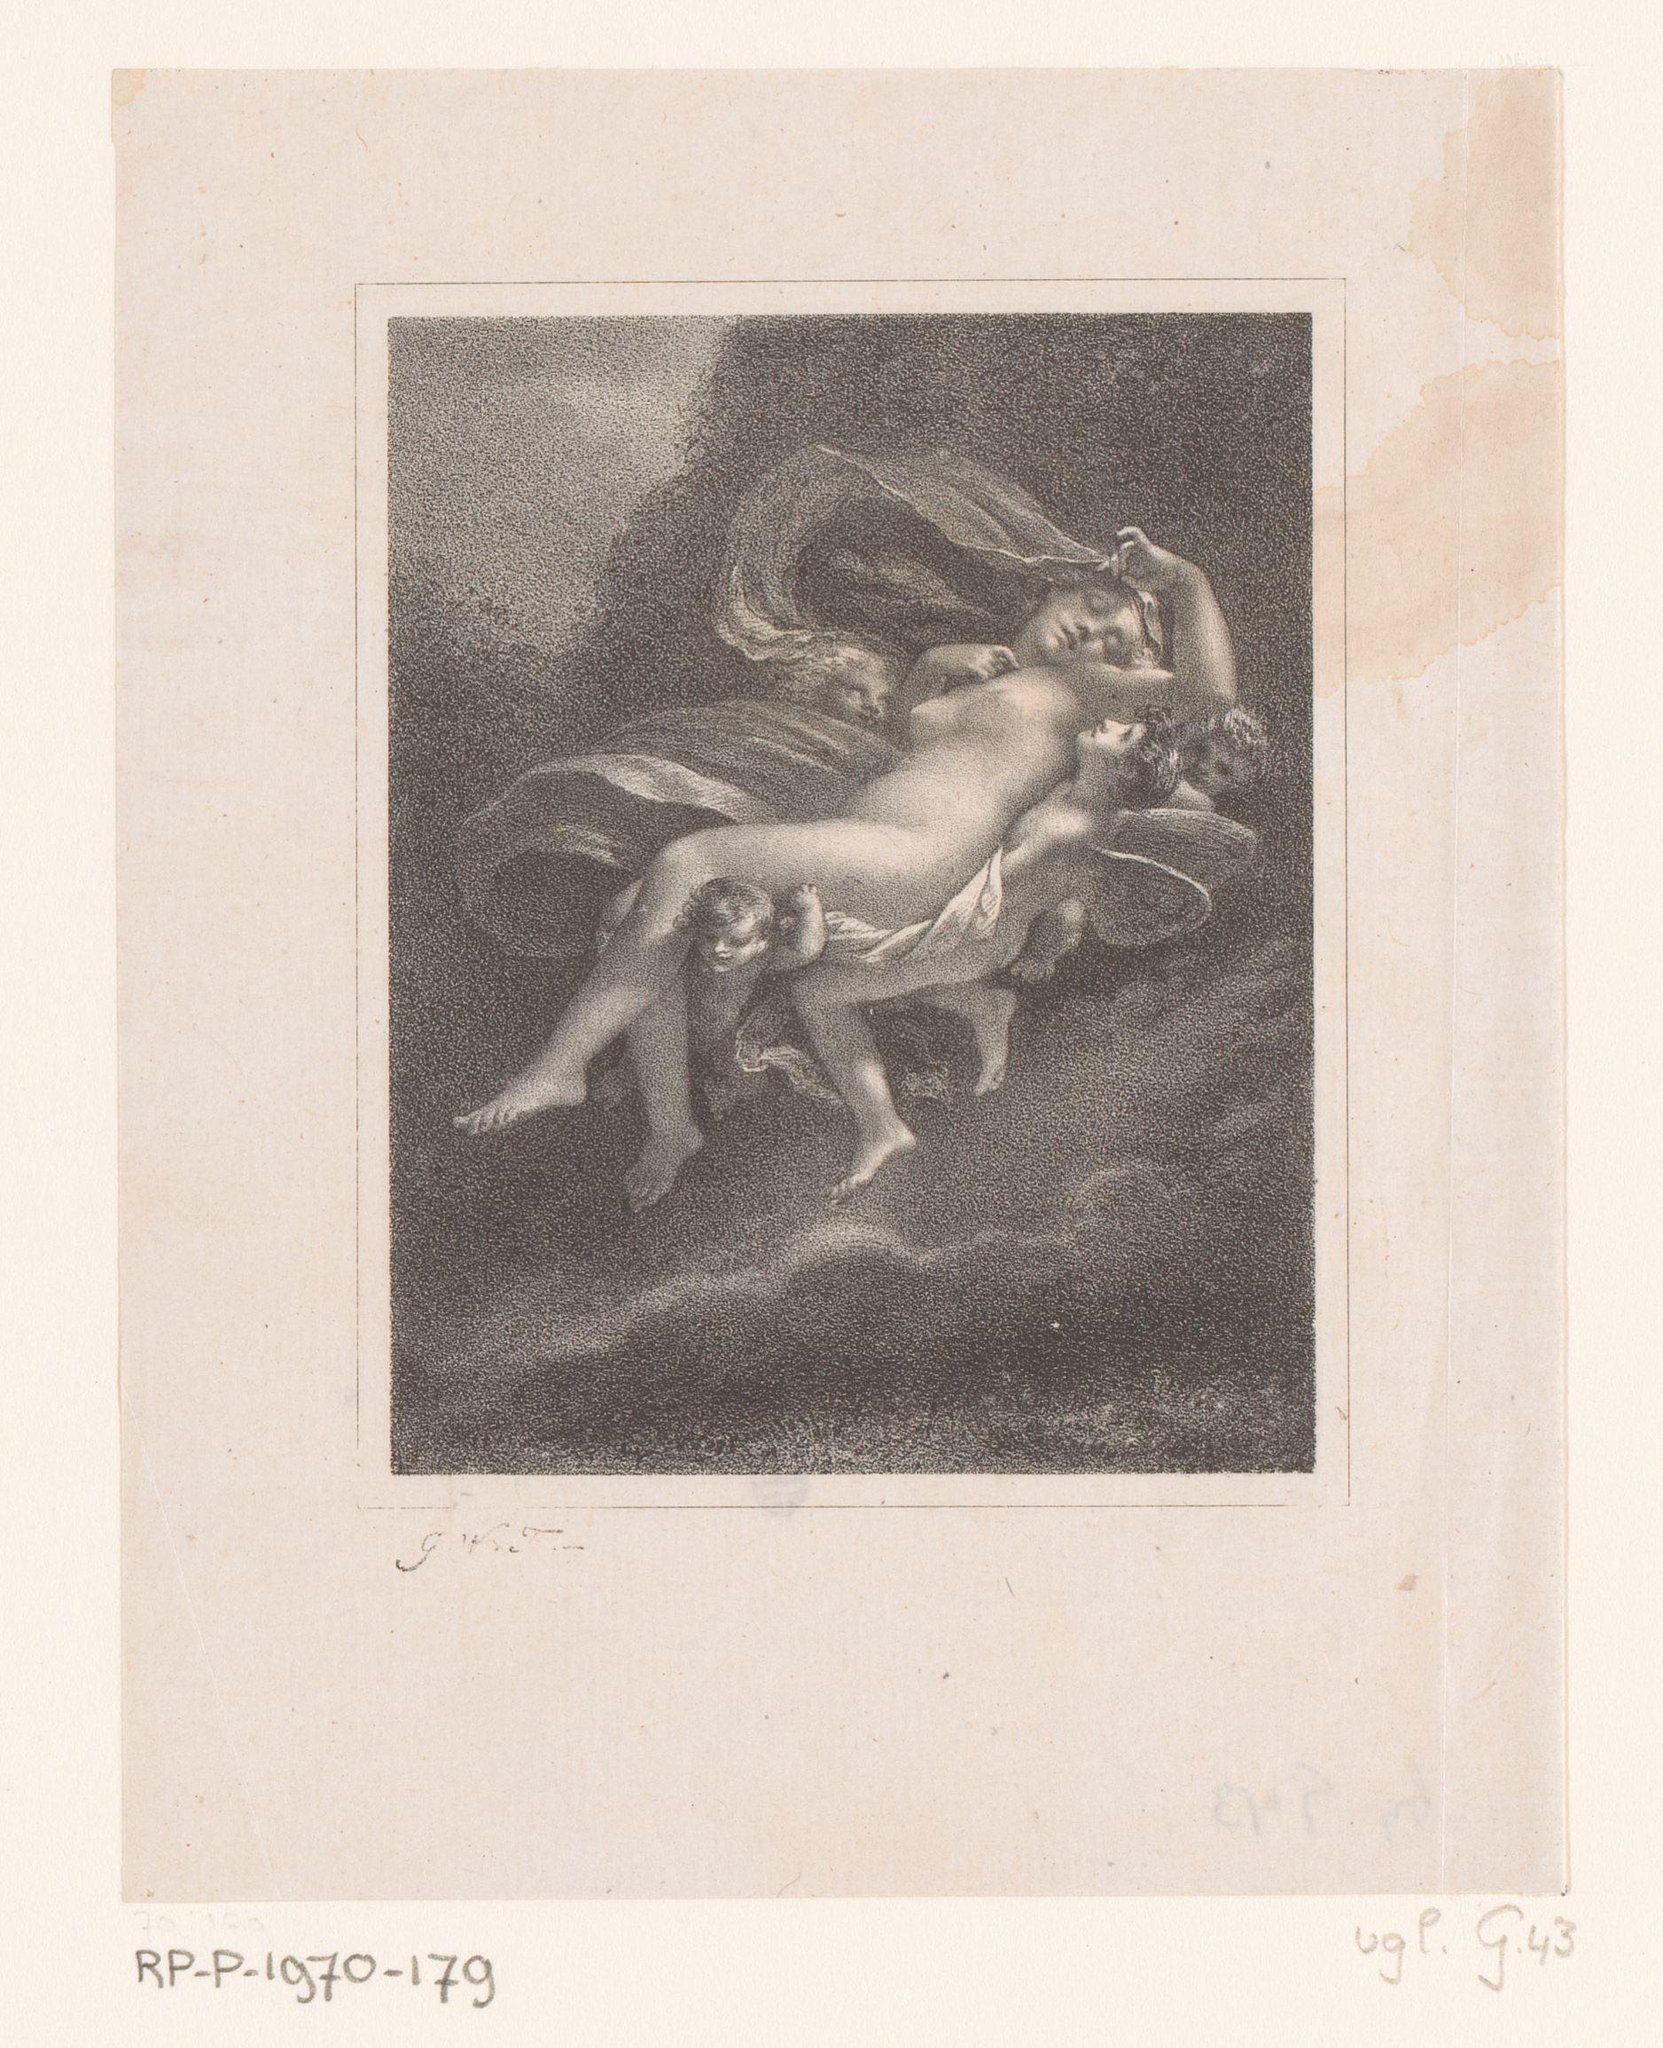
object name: print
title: L'Enlèvement de Psyche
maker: Anonymous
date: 1808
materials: paper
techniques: lithograph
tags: psyche is carried up to olympus by mercury, cupids: 'amores', 'amoretti', 'putti'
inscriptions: collector's mark: Lugt 2228a, collector's mark: Lugt 2760